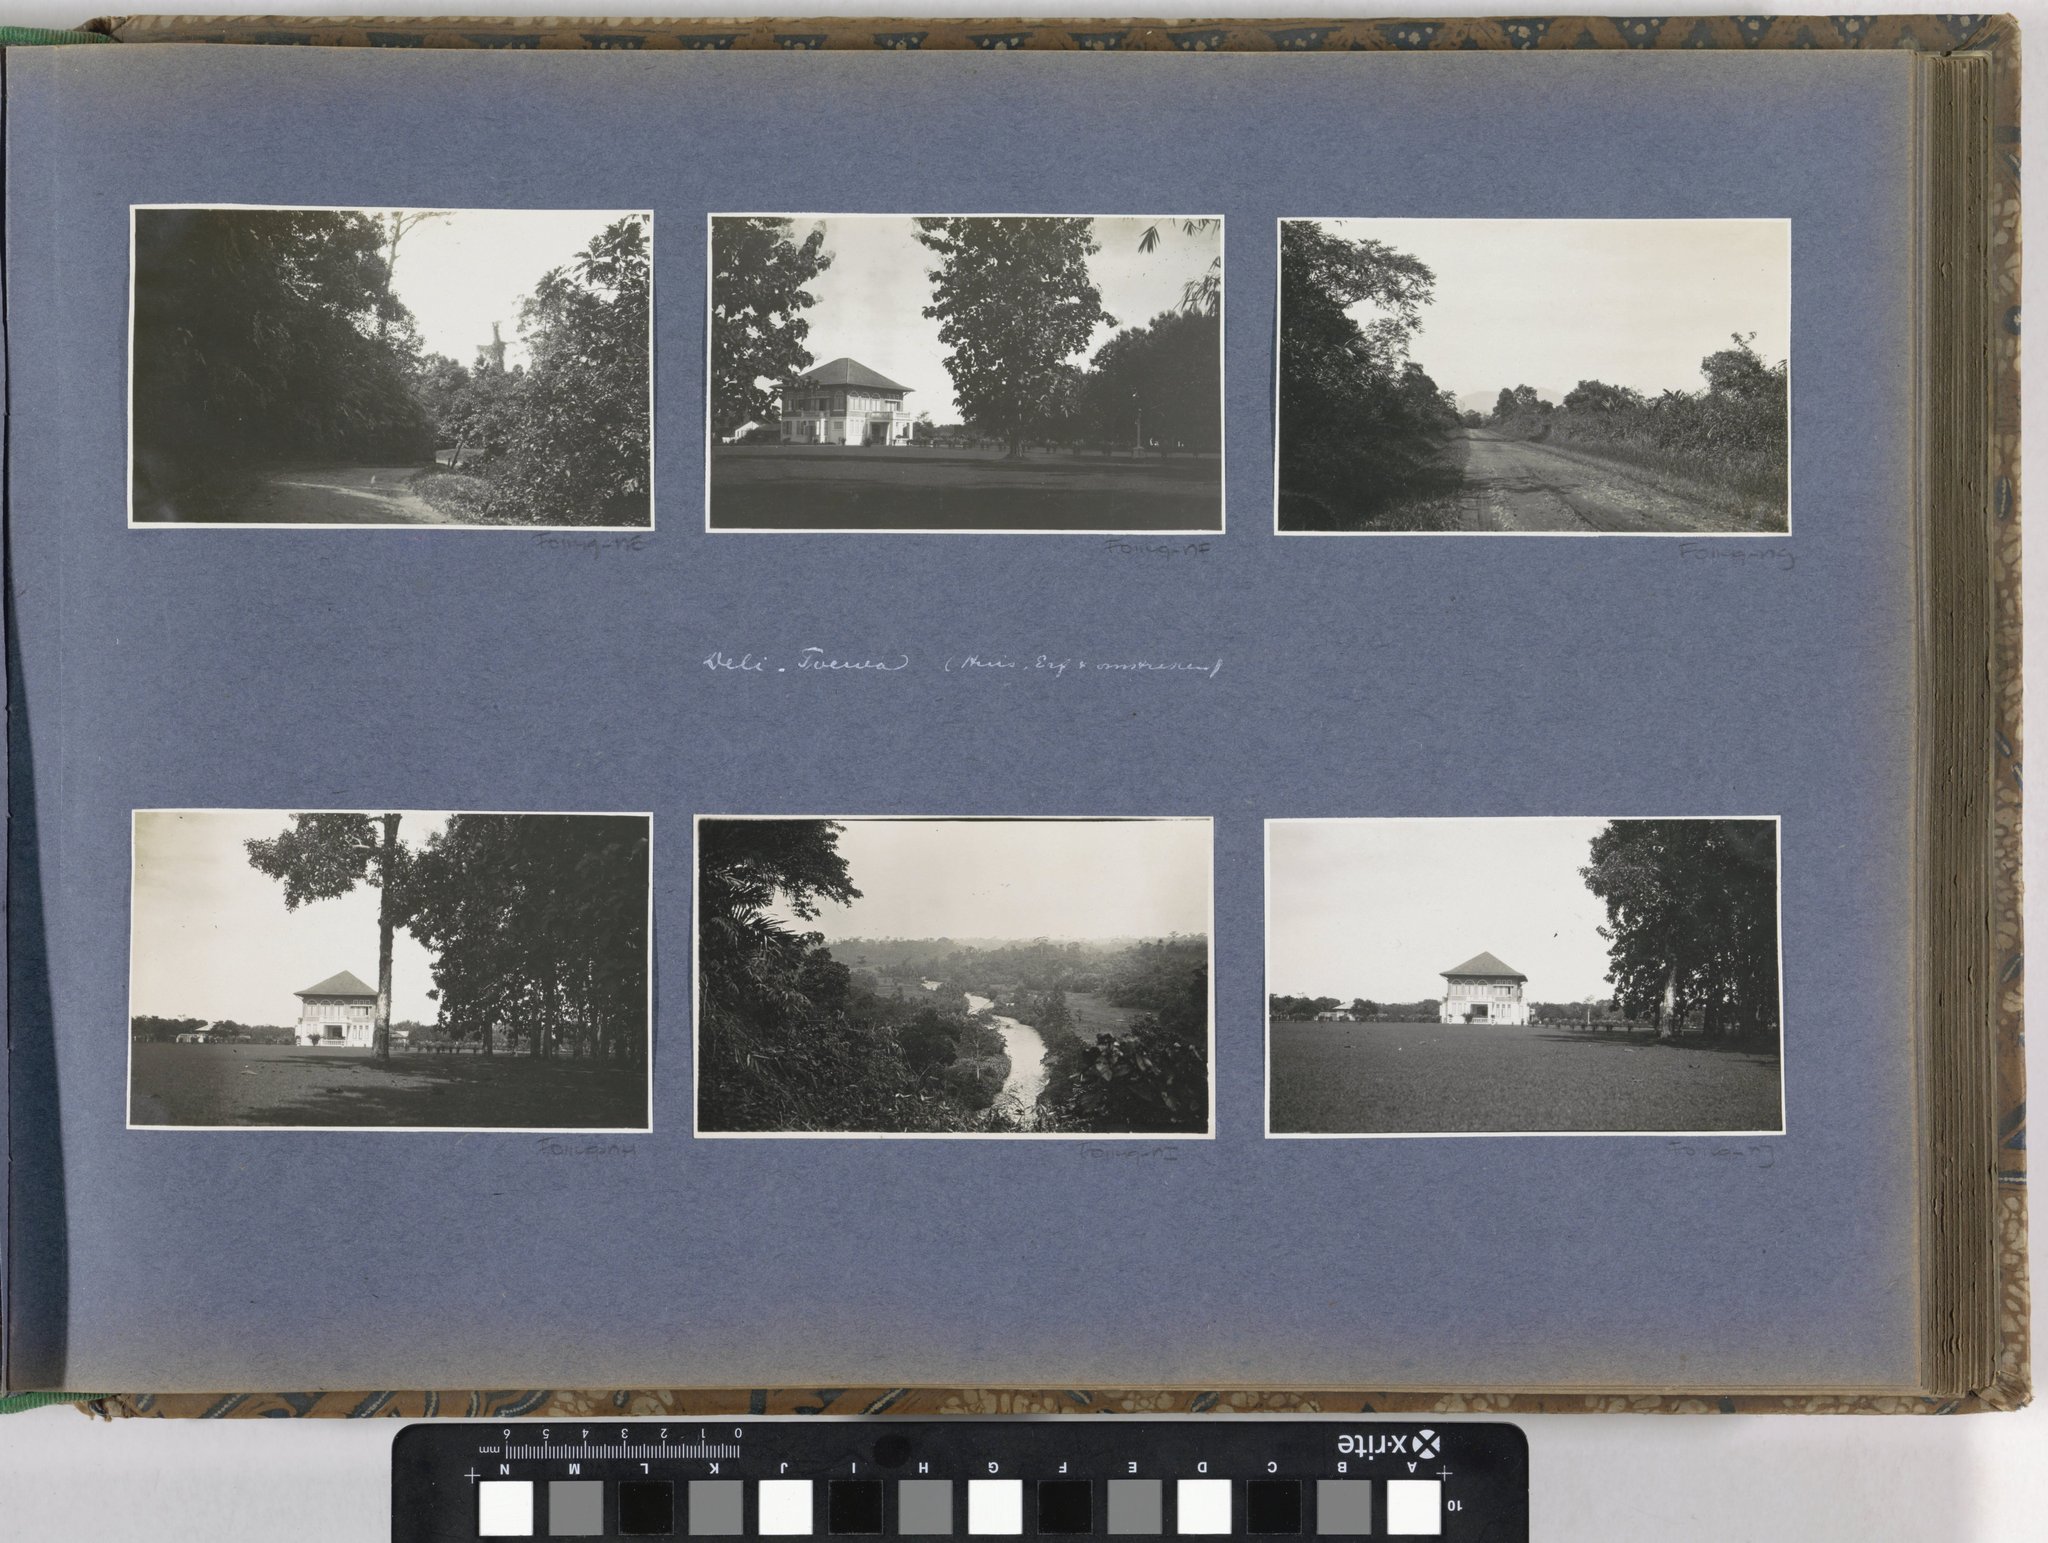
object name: album leaf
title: Huis en tuin in Deli-Toewa op Sumatra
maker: Anonymous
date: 1900-1920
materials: paper, photographic support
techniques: gelatin silver print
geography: sumatra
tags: plantation, garden, rural housing, e.g. country-house, villa, cottage, sumatra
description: Onderdeel van reisalbum met foto's van bedrijvigheid en bezienswaardigheden op Sumatra en Java en van de reis naar en van Nederlands-Indië.